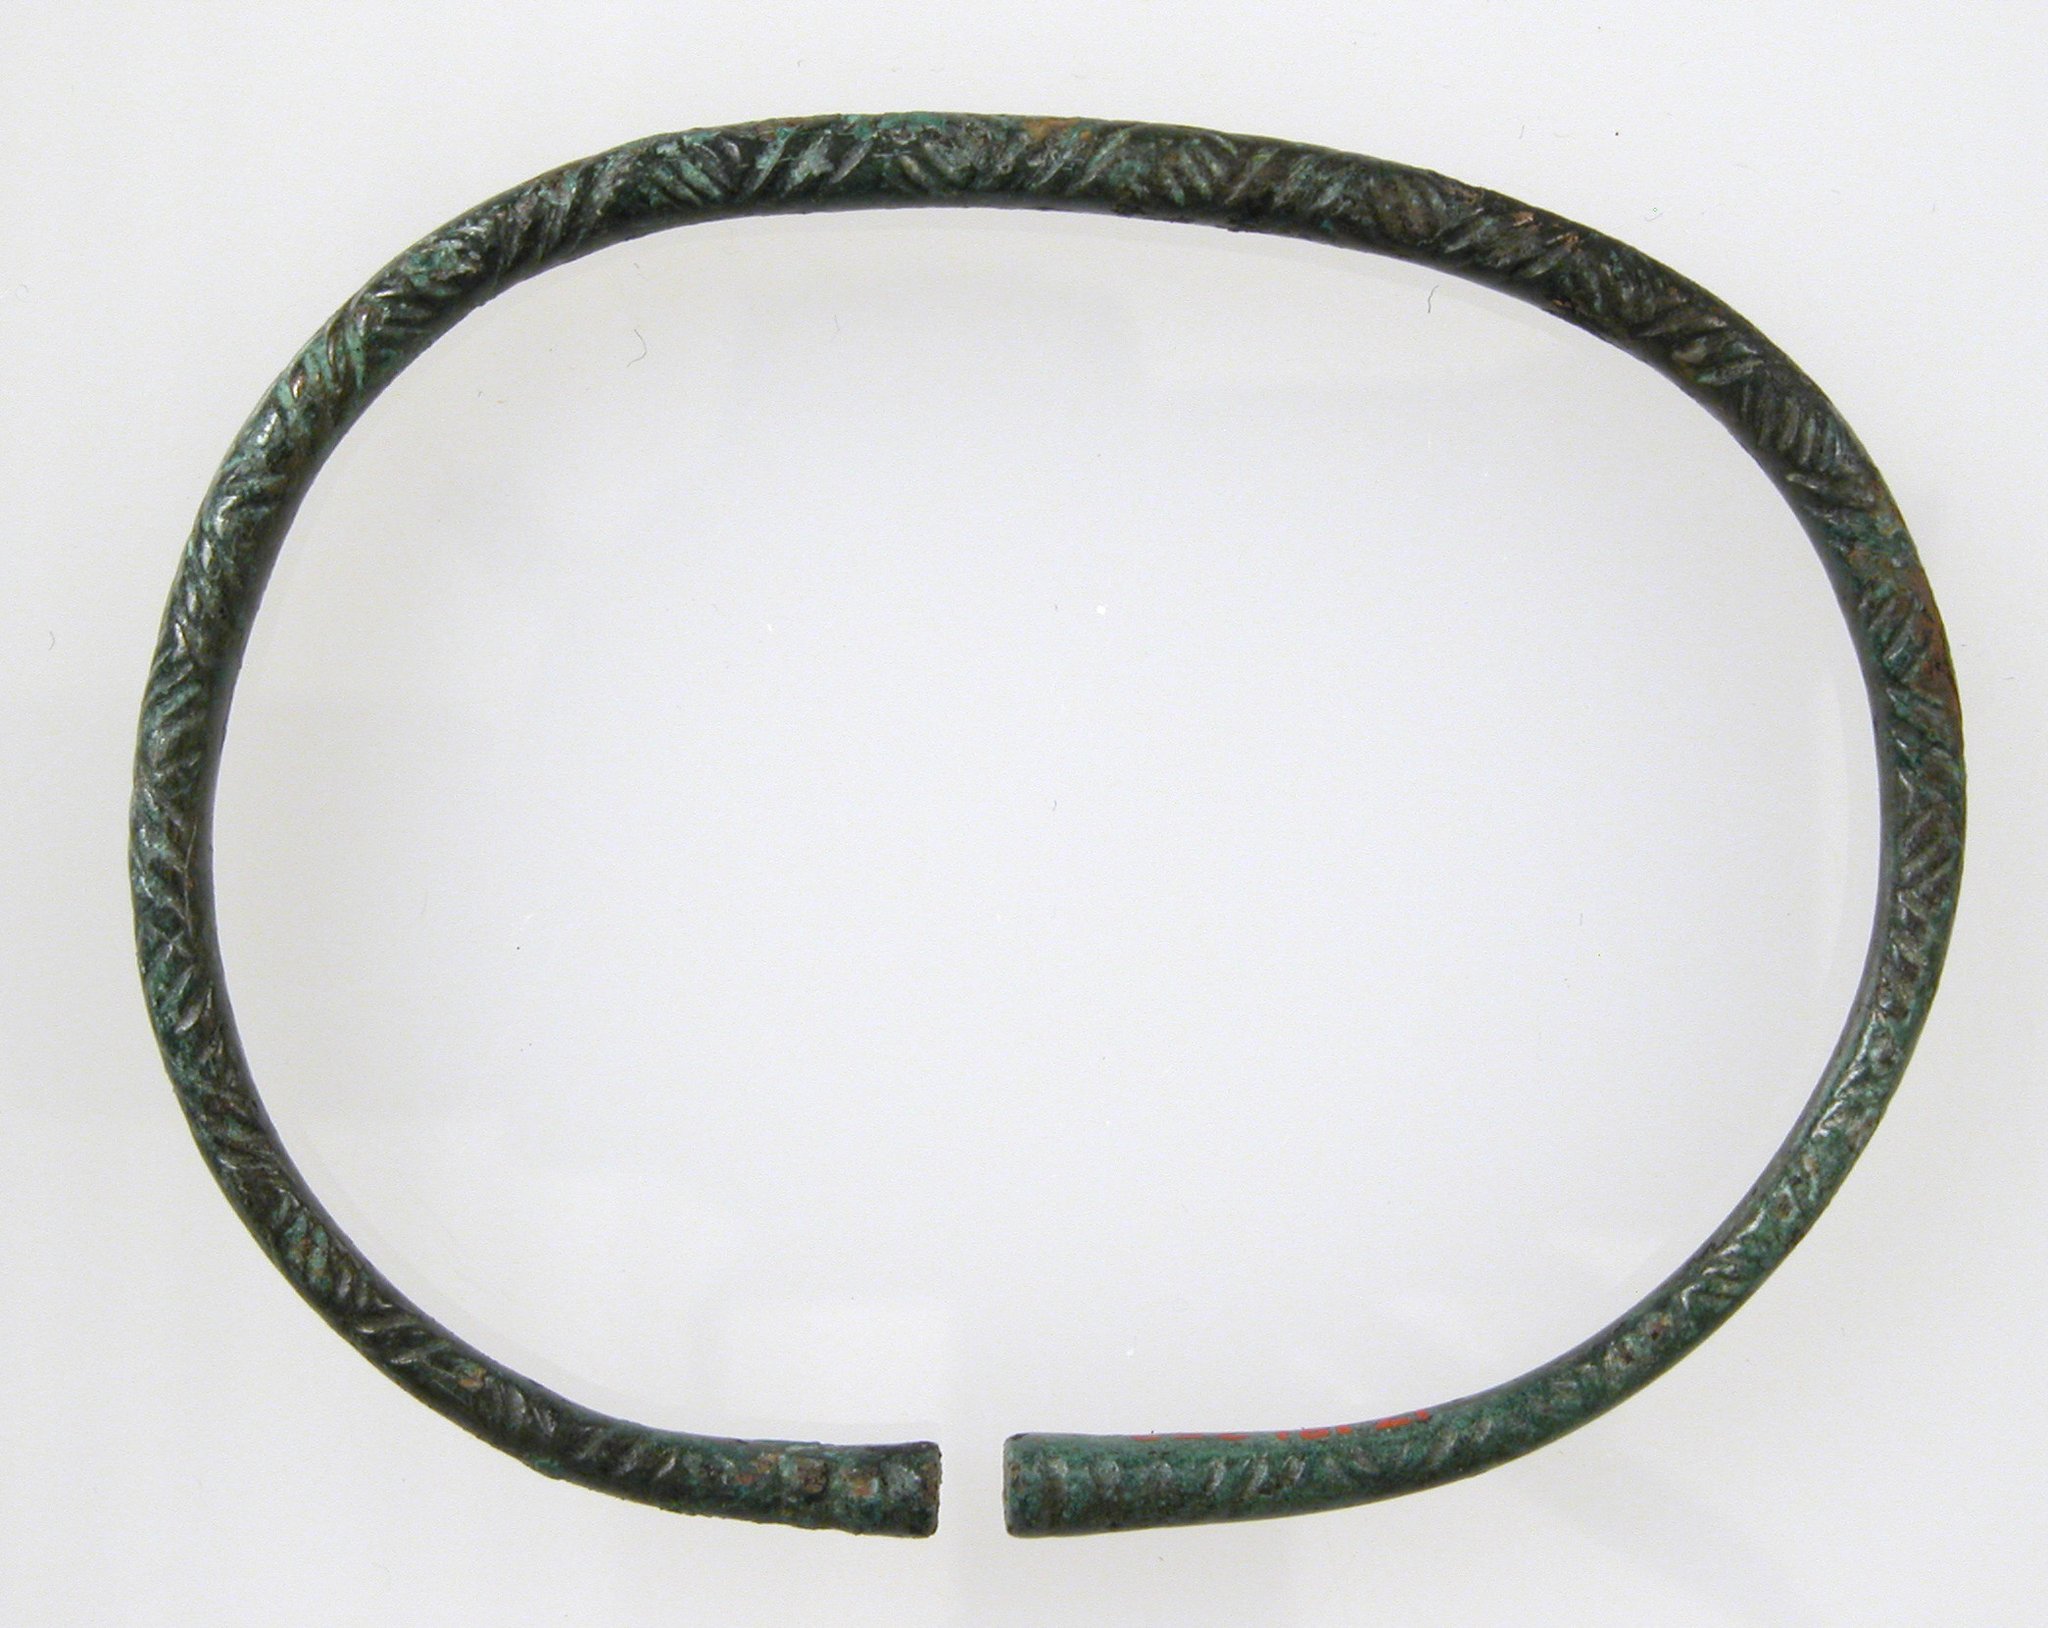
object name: bracelet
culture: celtic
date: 100-400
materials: copper alloy